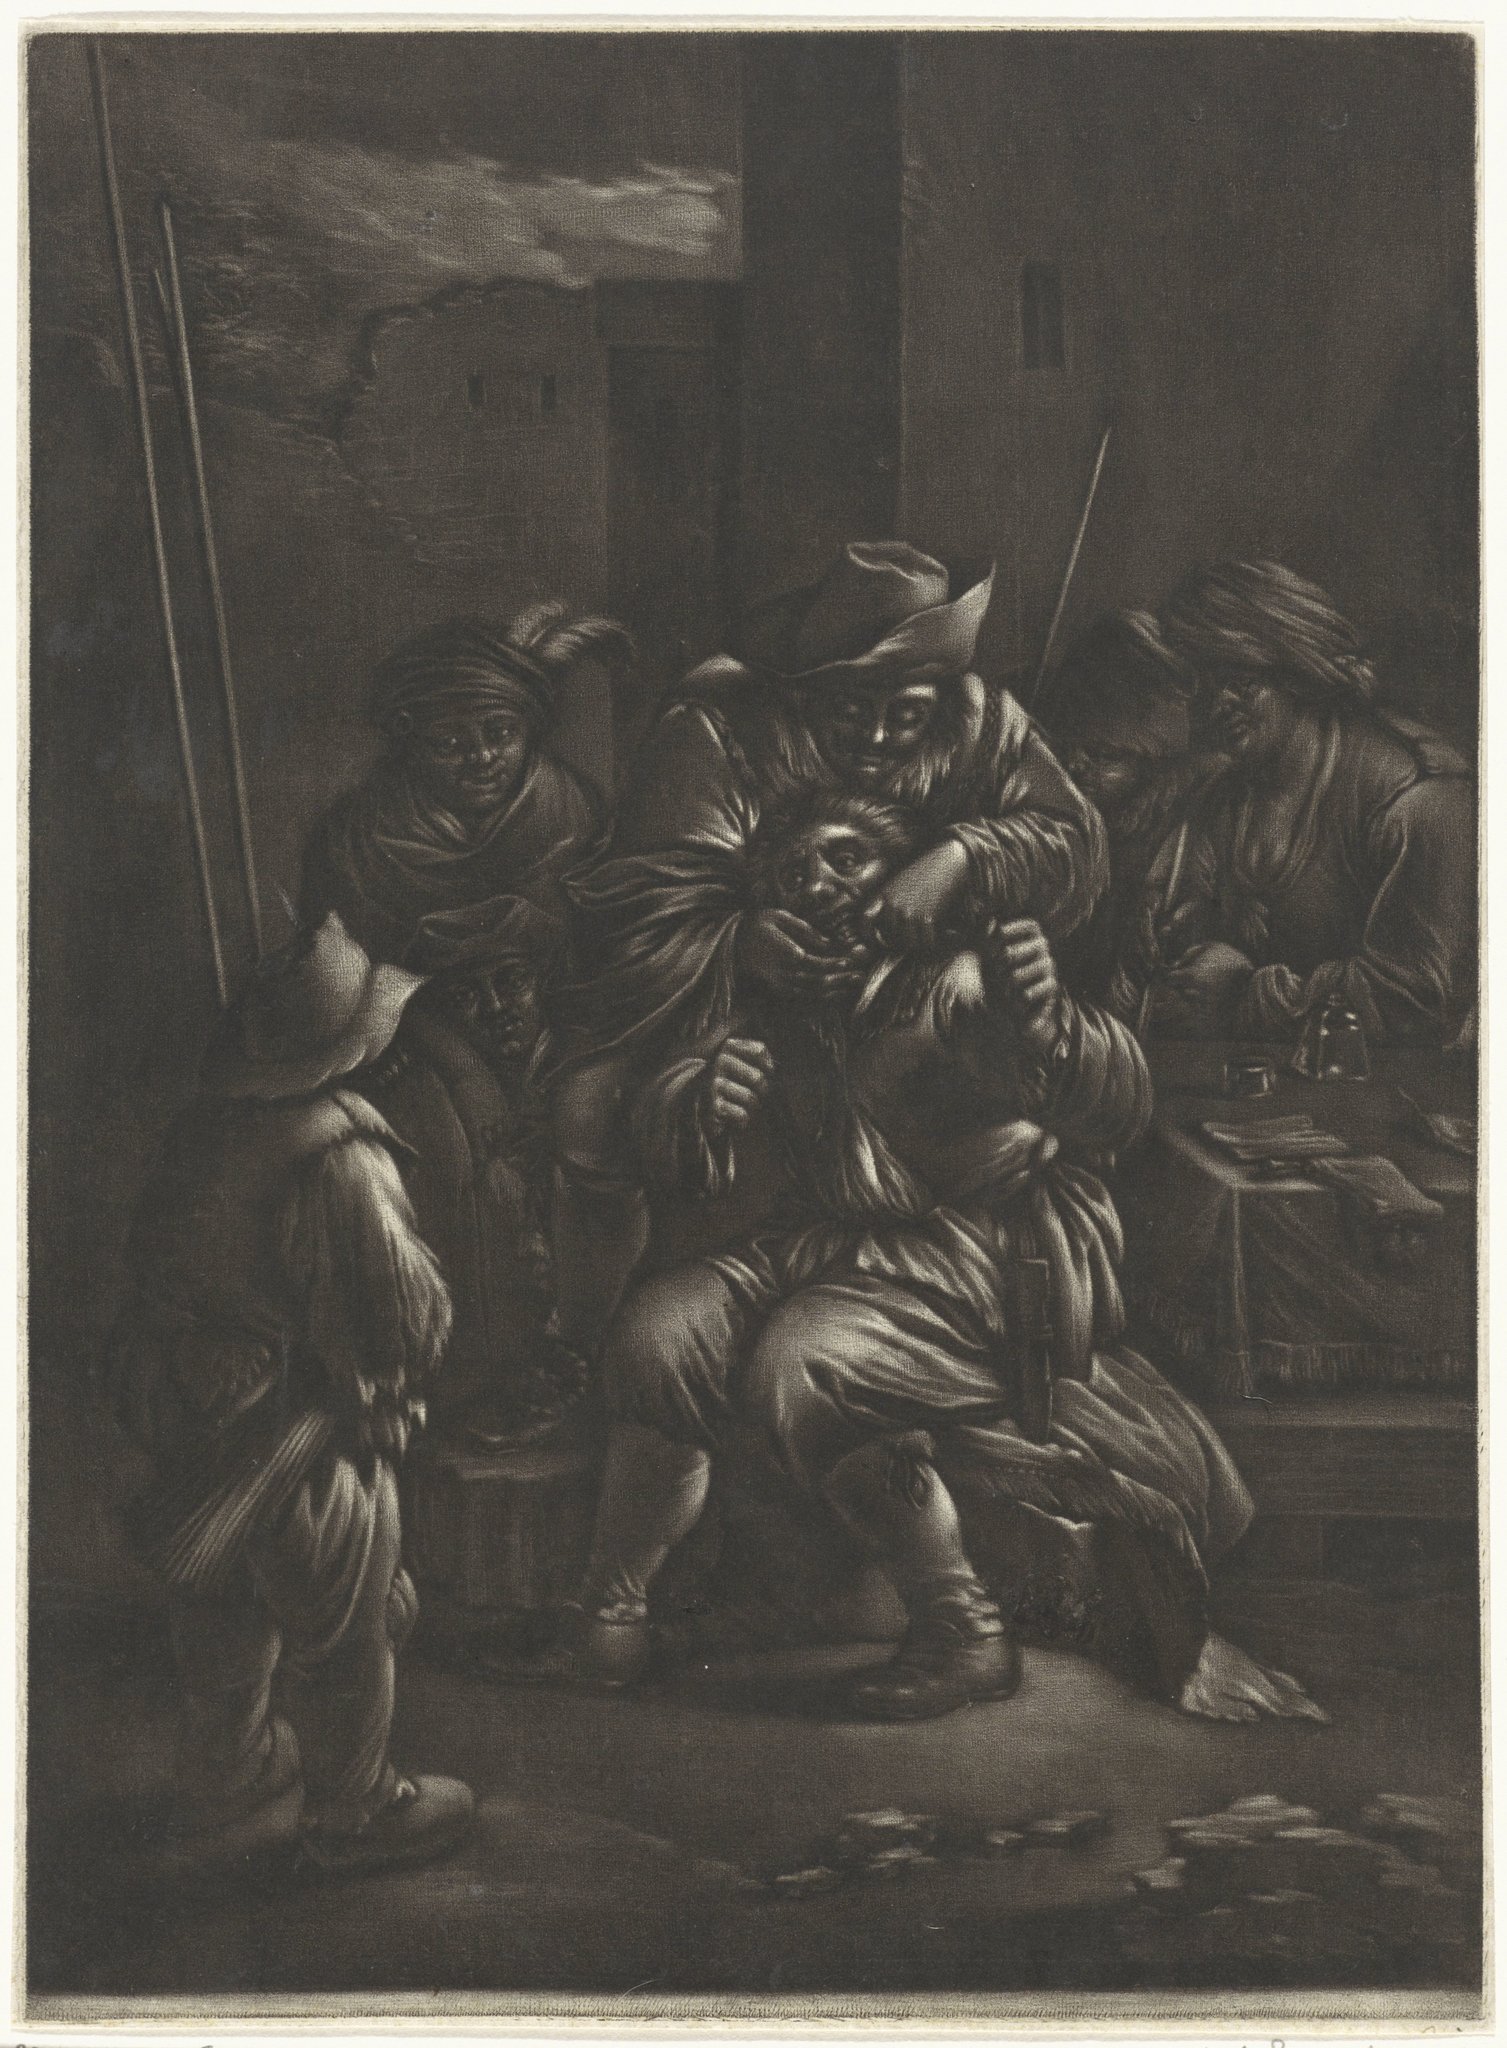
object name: print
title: Tandarts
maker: Anonymous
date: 1665-1750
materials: paper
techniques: mezzotint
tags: (barber as) dentist, quack extracting teeth or molars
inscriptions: collector's mark: Lugt 2228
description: Voor een herberg behandelt een kwakzalver (tandarts) een man. De patiënt heeft zijn vuisten gebald. Een groep omstanders staat rond het schouwspel.